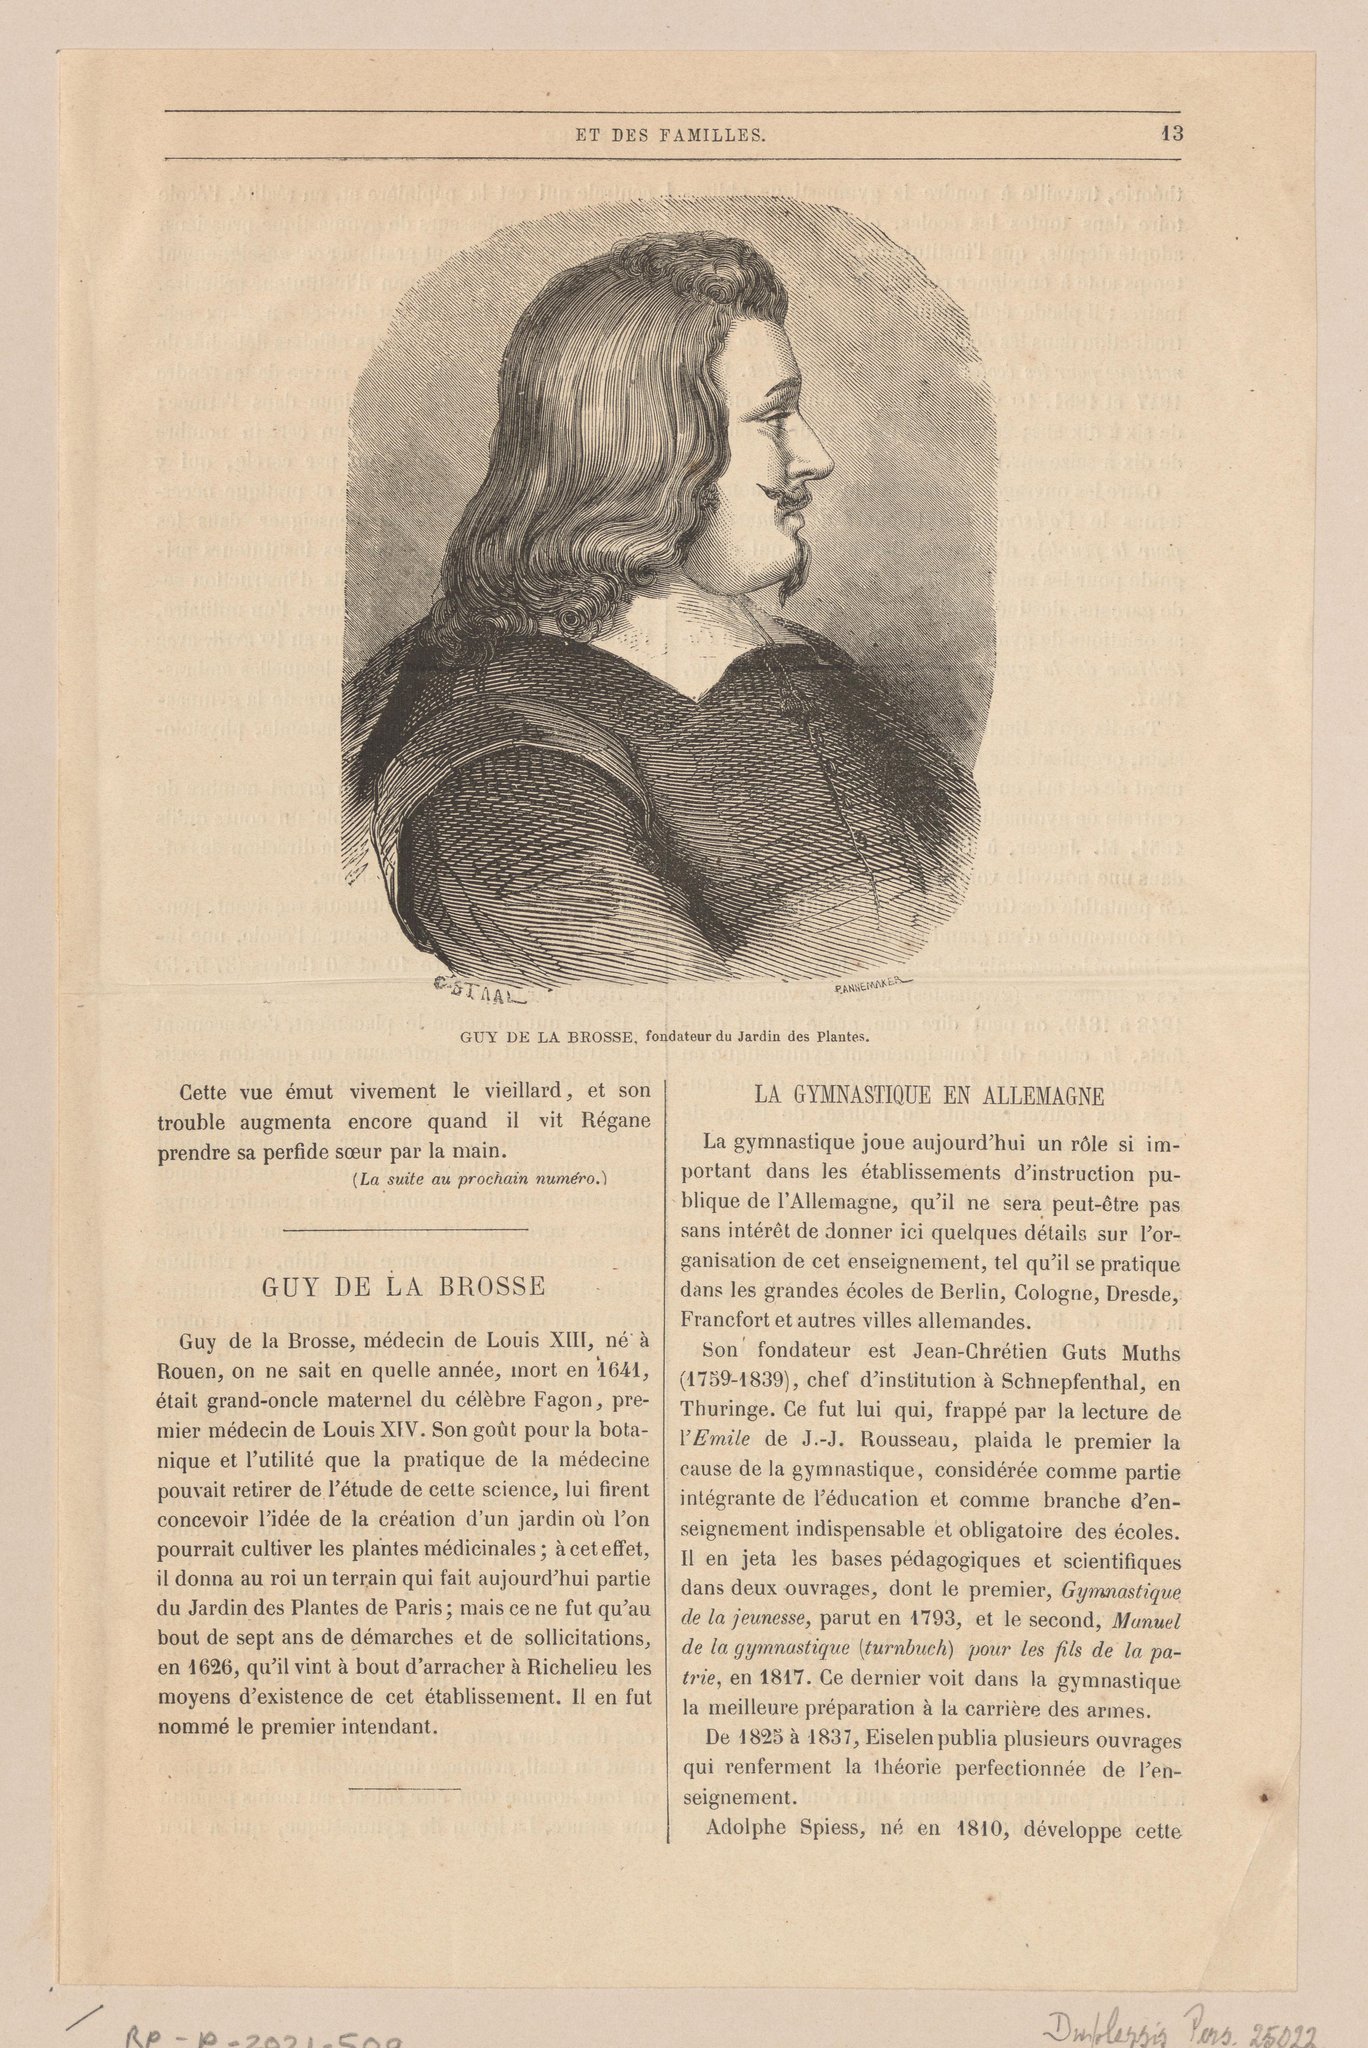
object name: print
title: Portret van Guy de la Brosse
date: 1867-1868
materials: paper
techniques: letterpress printing, engraving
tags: historical persons, physician, doctor (+ portrait of scholar, scientist)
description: Prent komt uit een editie van L'Ami de la Jeunesse et des Familles, ca. 1867-1868.